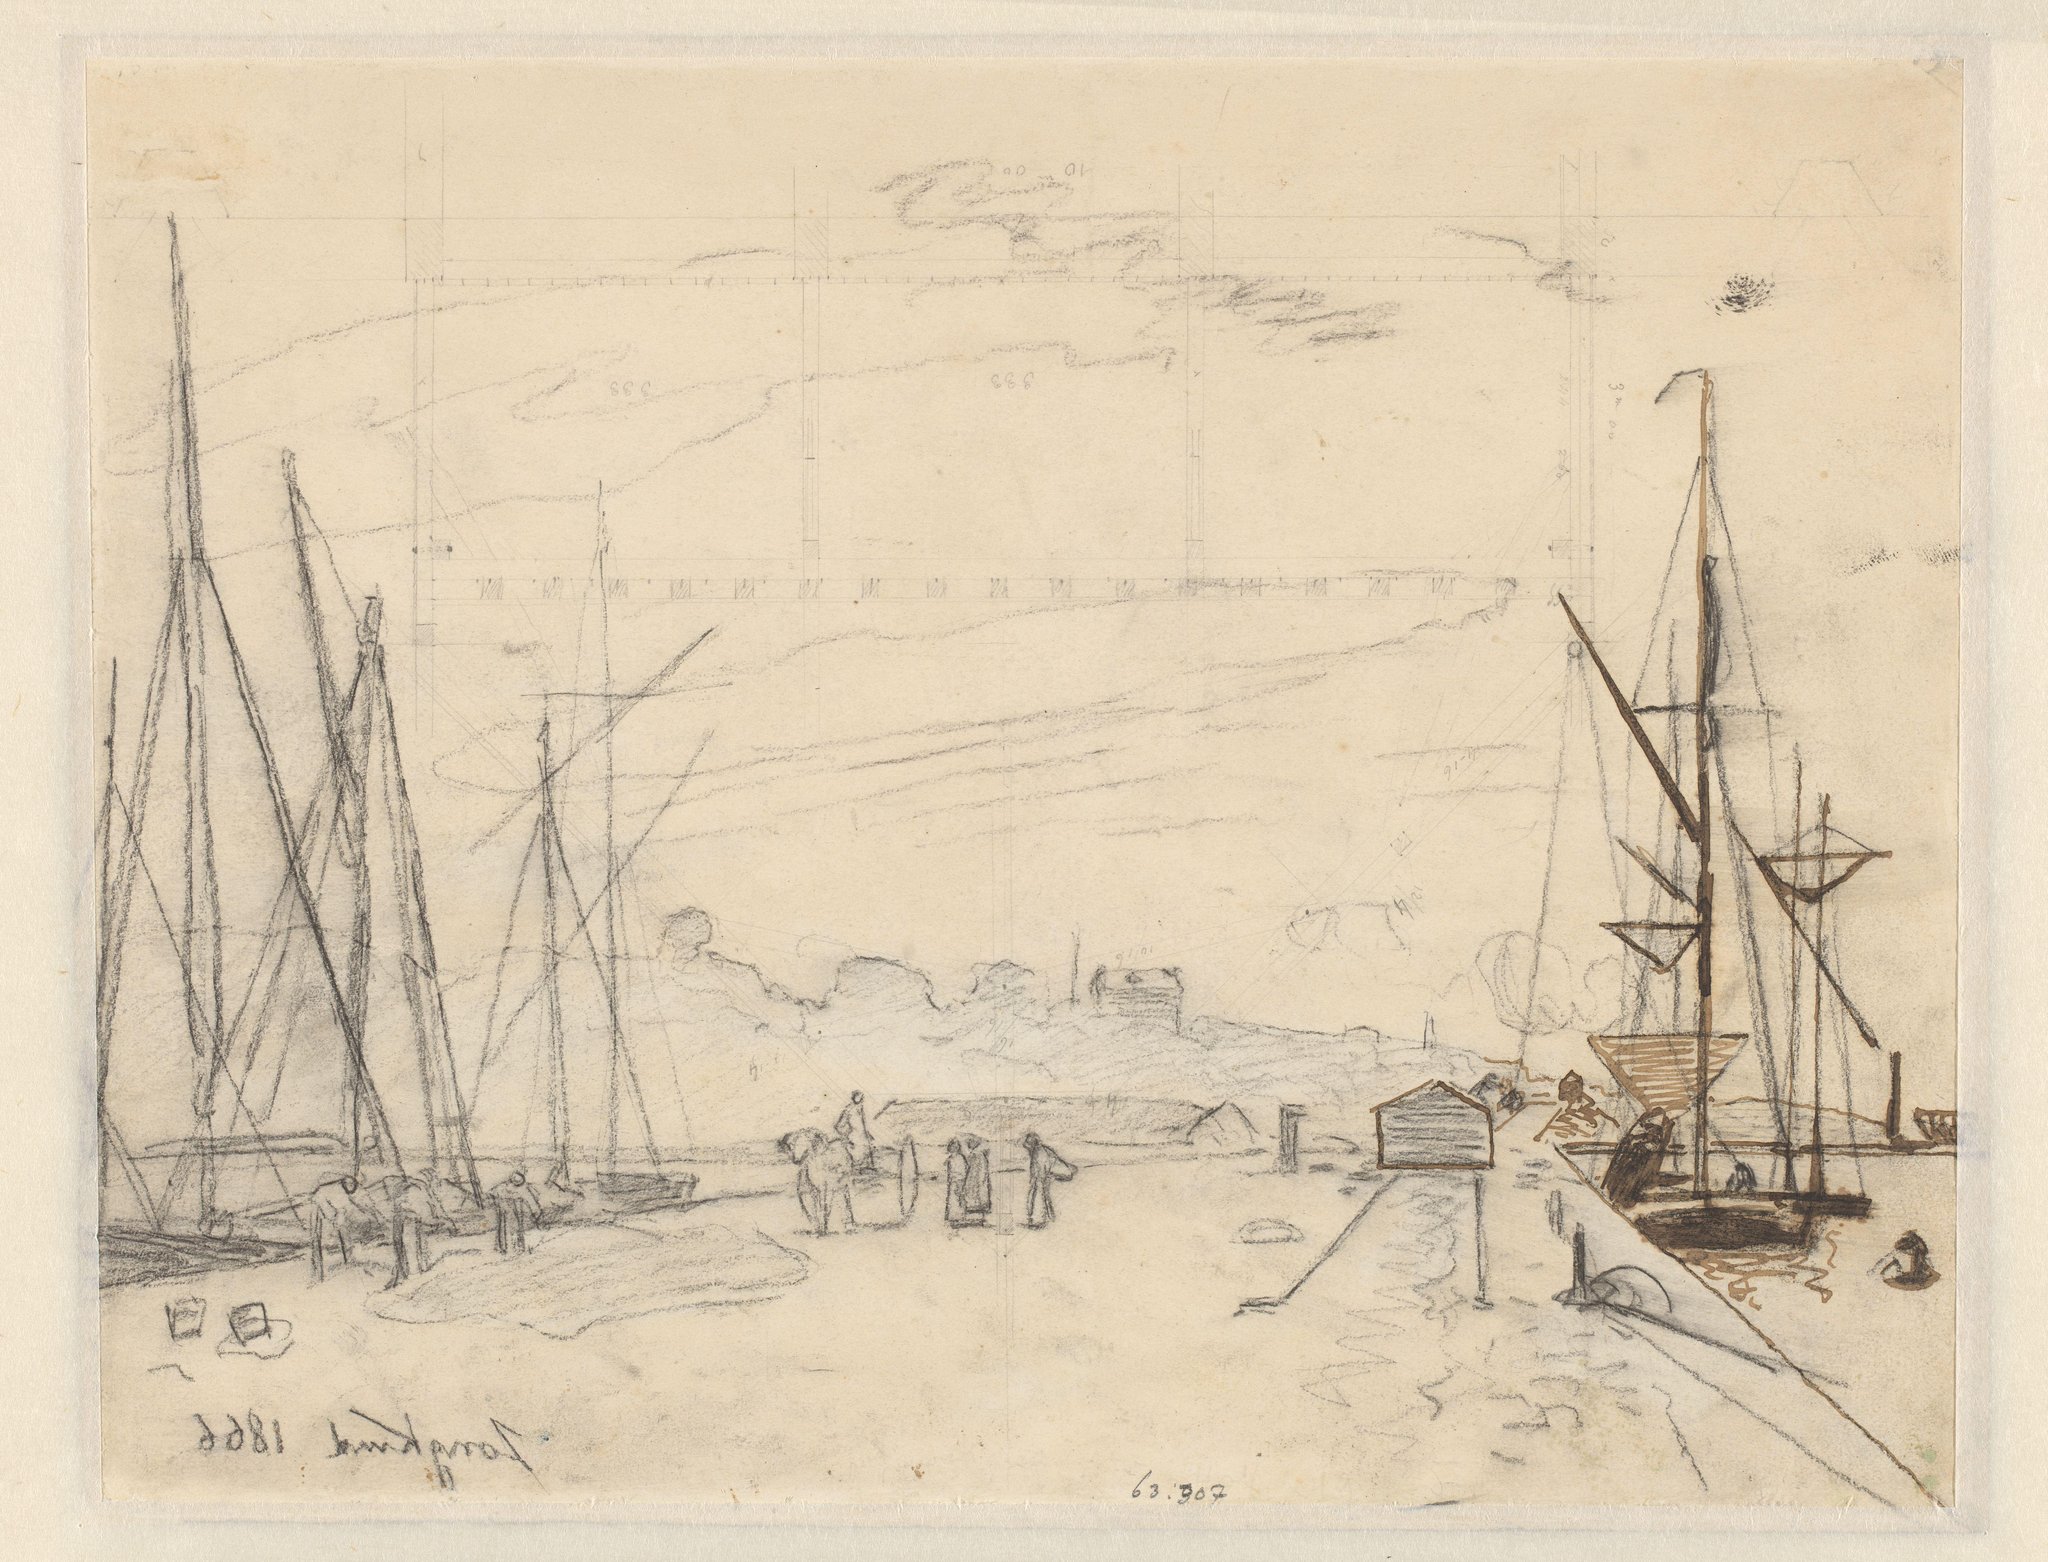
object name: drawing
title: Gezicht op de haven van Honfleur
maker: johan barthold jongkind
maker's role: draughtsman, painter, print maker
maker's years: 1819-1891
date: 1866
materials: chalk, ink, paper, pencil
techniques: pen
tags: harbour, sailing-ship, sailing-boat, station; shelter (railway, tramway), france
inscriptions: date: ‘1866’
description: Voorstelling op voorzijde (RP-T-1963-307(R)) doorgetrokken en aangevuld. Ontwerp voor een prent.